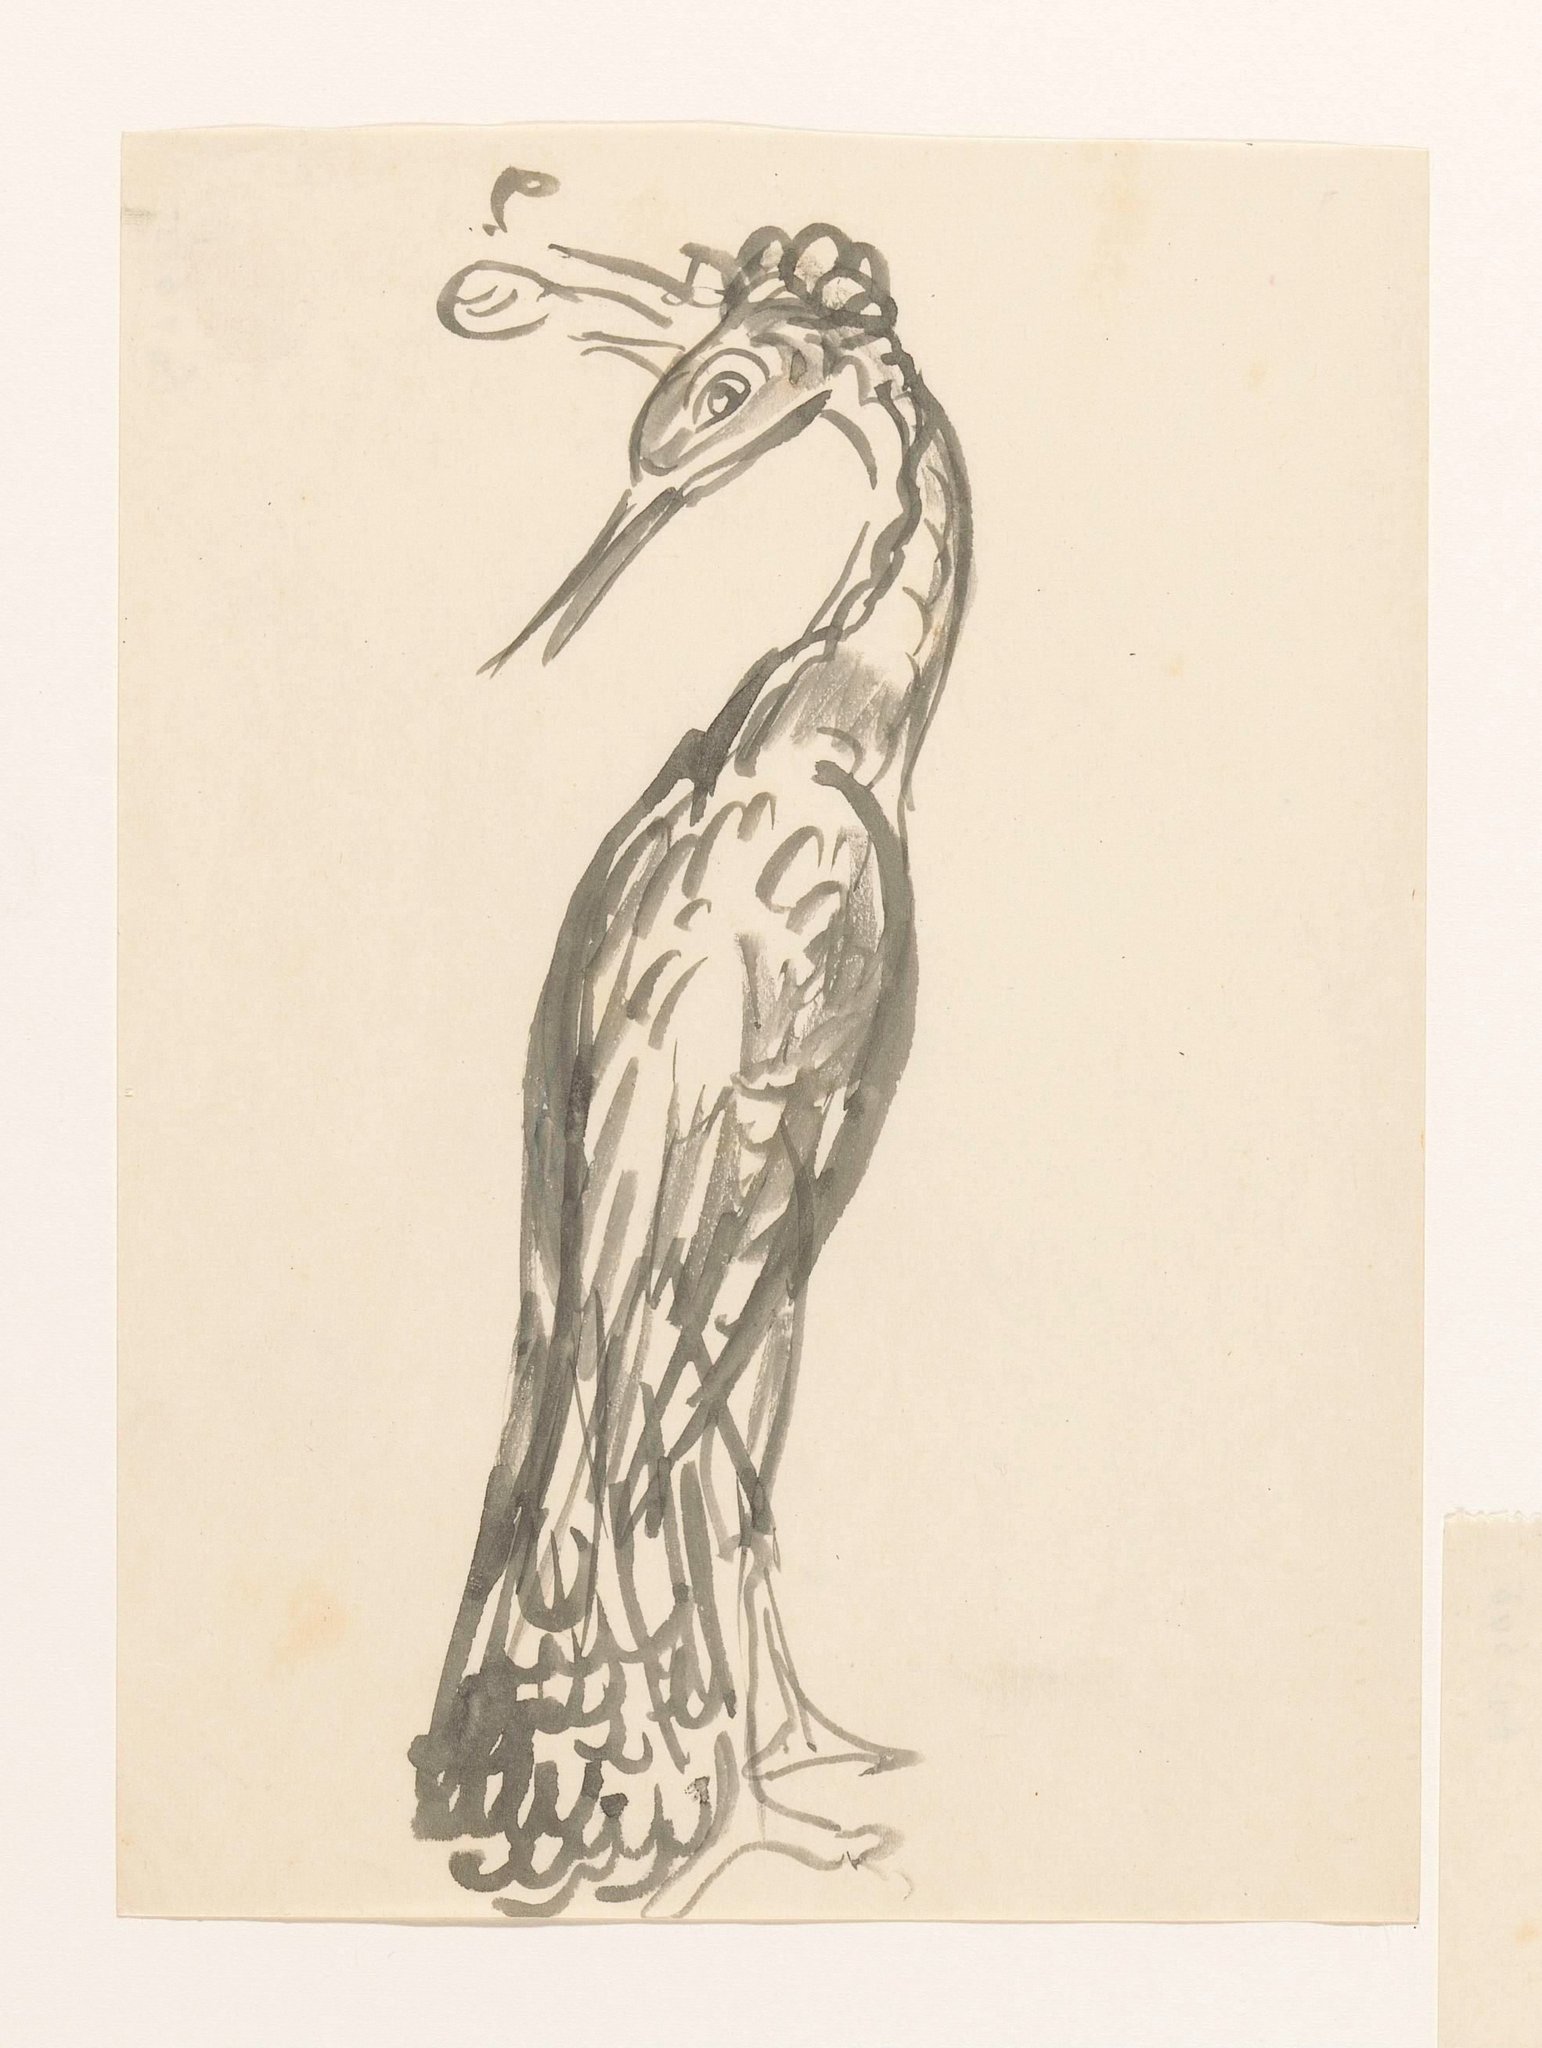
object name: drawing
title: Reiger met zijn kop naar achter gedraaid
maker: leo gestel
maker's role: draughtsman, print maker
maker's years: 1881-1941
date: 1891-1941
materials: paper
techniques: brush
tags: shore-birds and wading-birds: heron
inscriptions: collector's mark: Lugt 2228